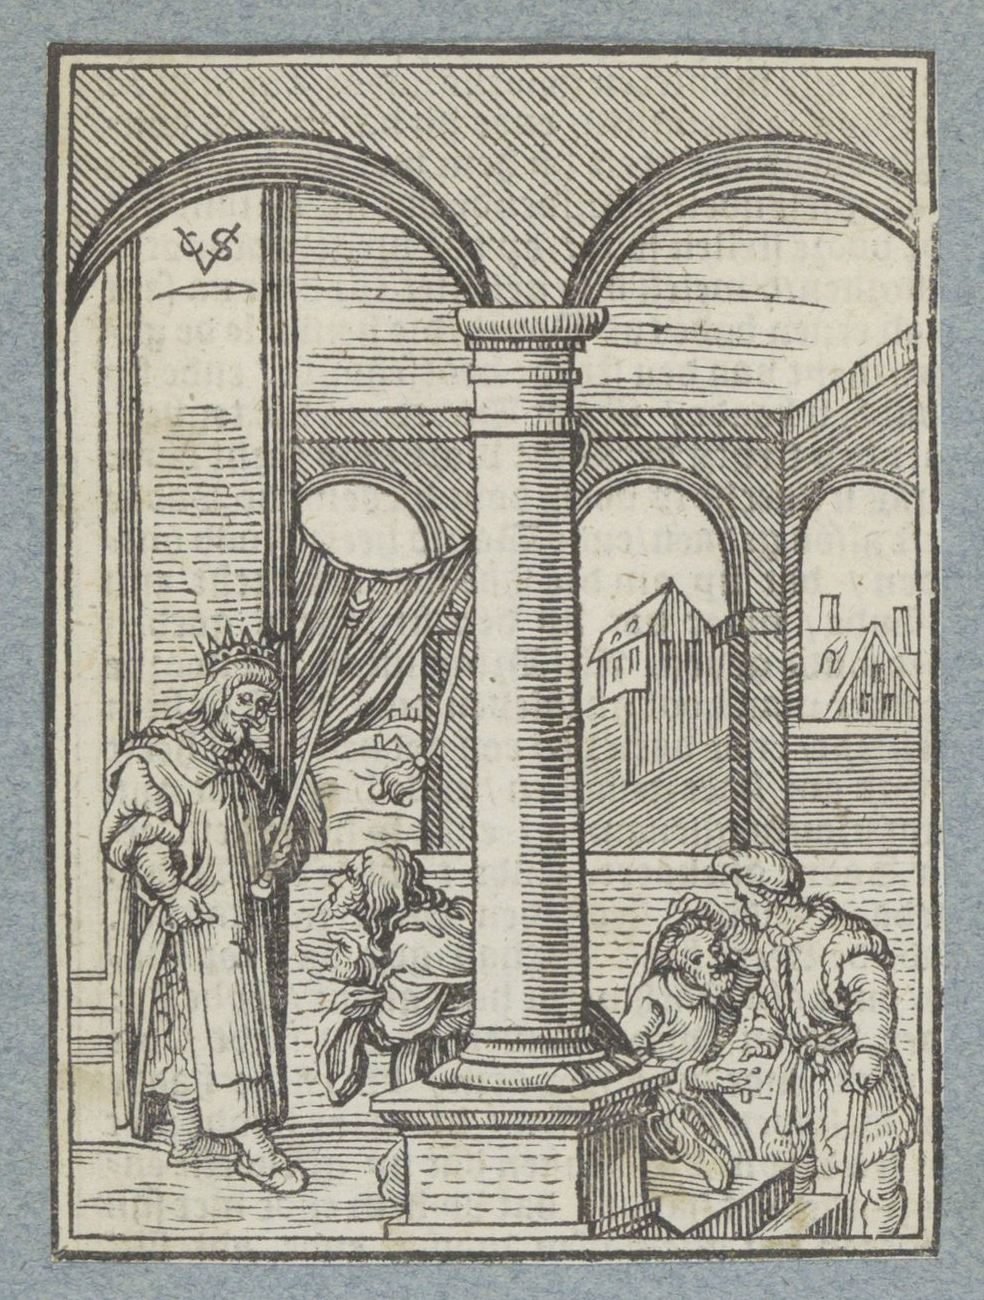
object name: print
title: Natan wijst David op zijn zonden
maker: pieter jacobsz. paets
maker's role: publisher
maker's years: 1587-1667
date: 1645-1657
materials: paper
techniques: letterpress printing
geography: amsterdam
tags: david rebuked by nathan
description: De prent werd gemaakt voor de uitgaven van P.J. Paets uit Amsterdam. Ze komt in ieder geval voor in: Bibels Tresoor ofte der zielen lusthof. Amsterdam, P.J. Paets, 1646. Mogelijk ook in: Historien ende Prophetien. [Amsterdam], P.J. Paets, 1645.